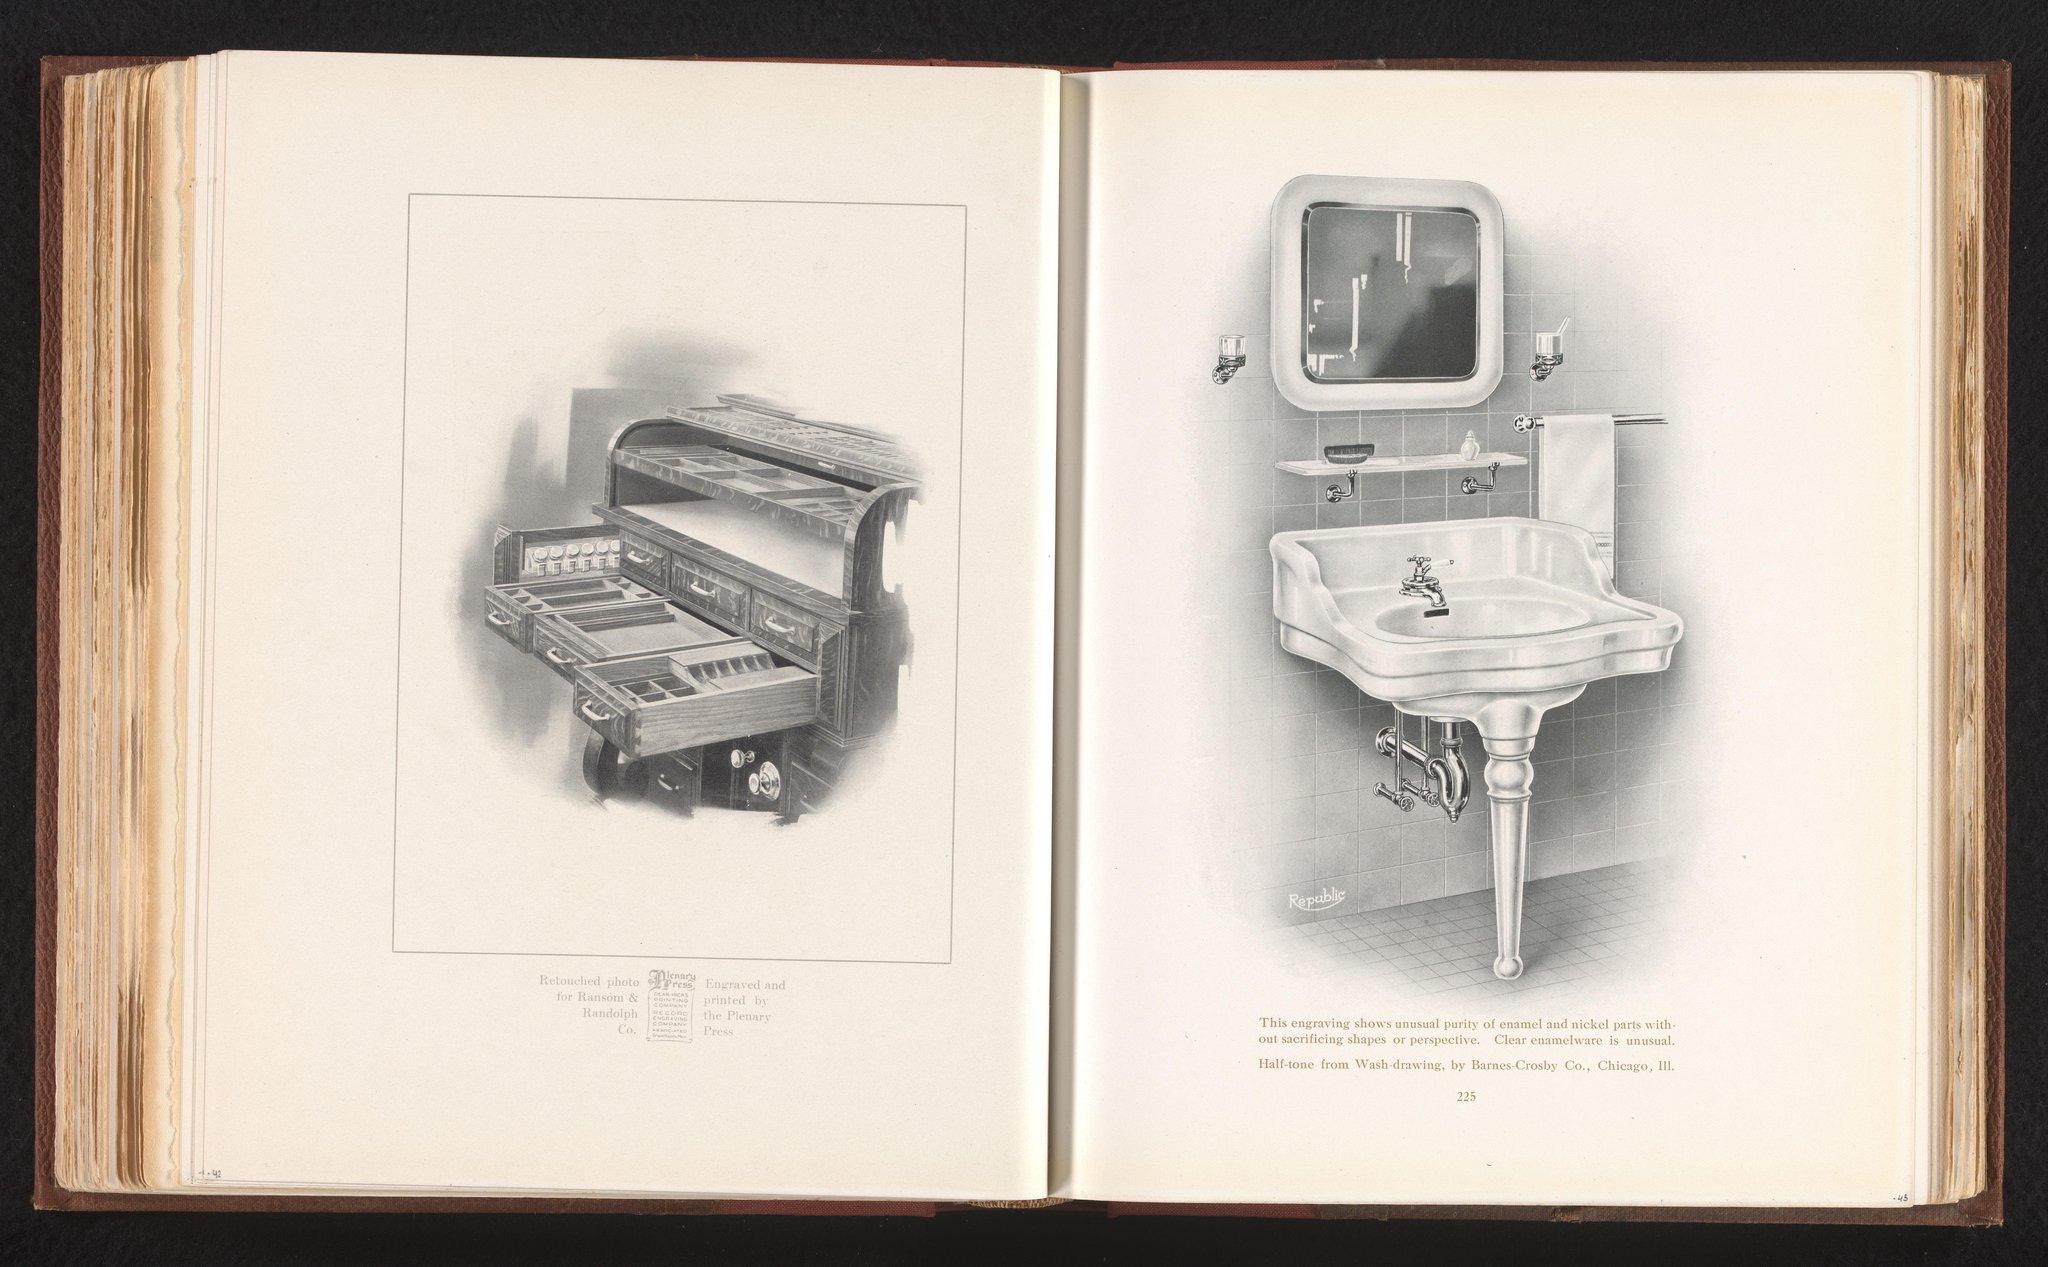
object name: photomechanical print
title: Secretaire met kassalade en kluis van Ransom & Randolph, voor een catalogus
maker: Anonymous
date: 1904-1909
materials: paper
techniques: autotype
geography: grand rapids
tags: furniture for storage